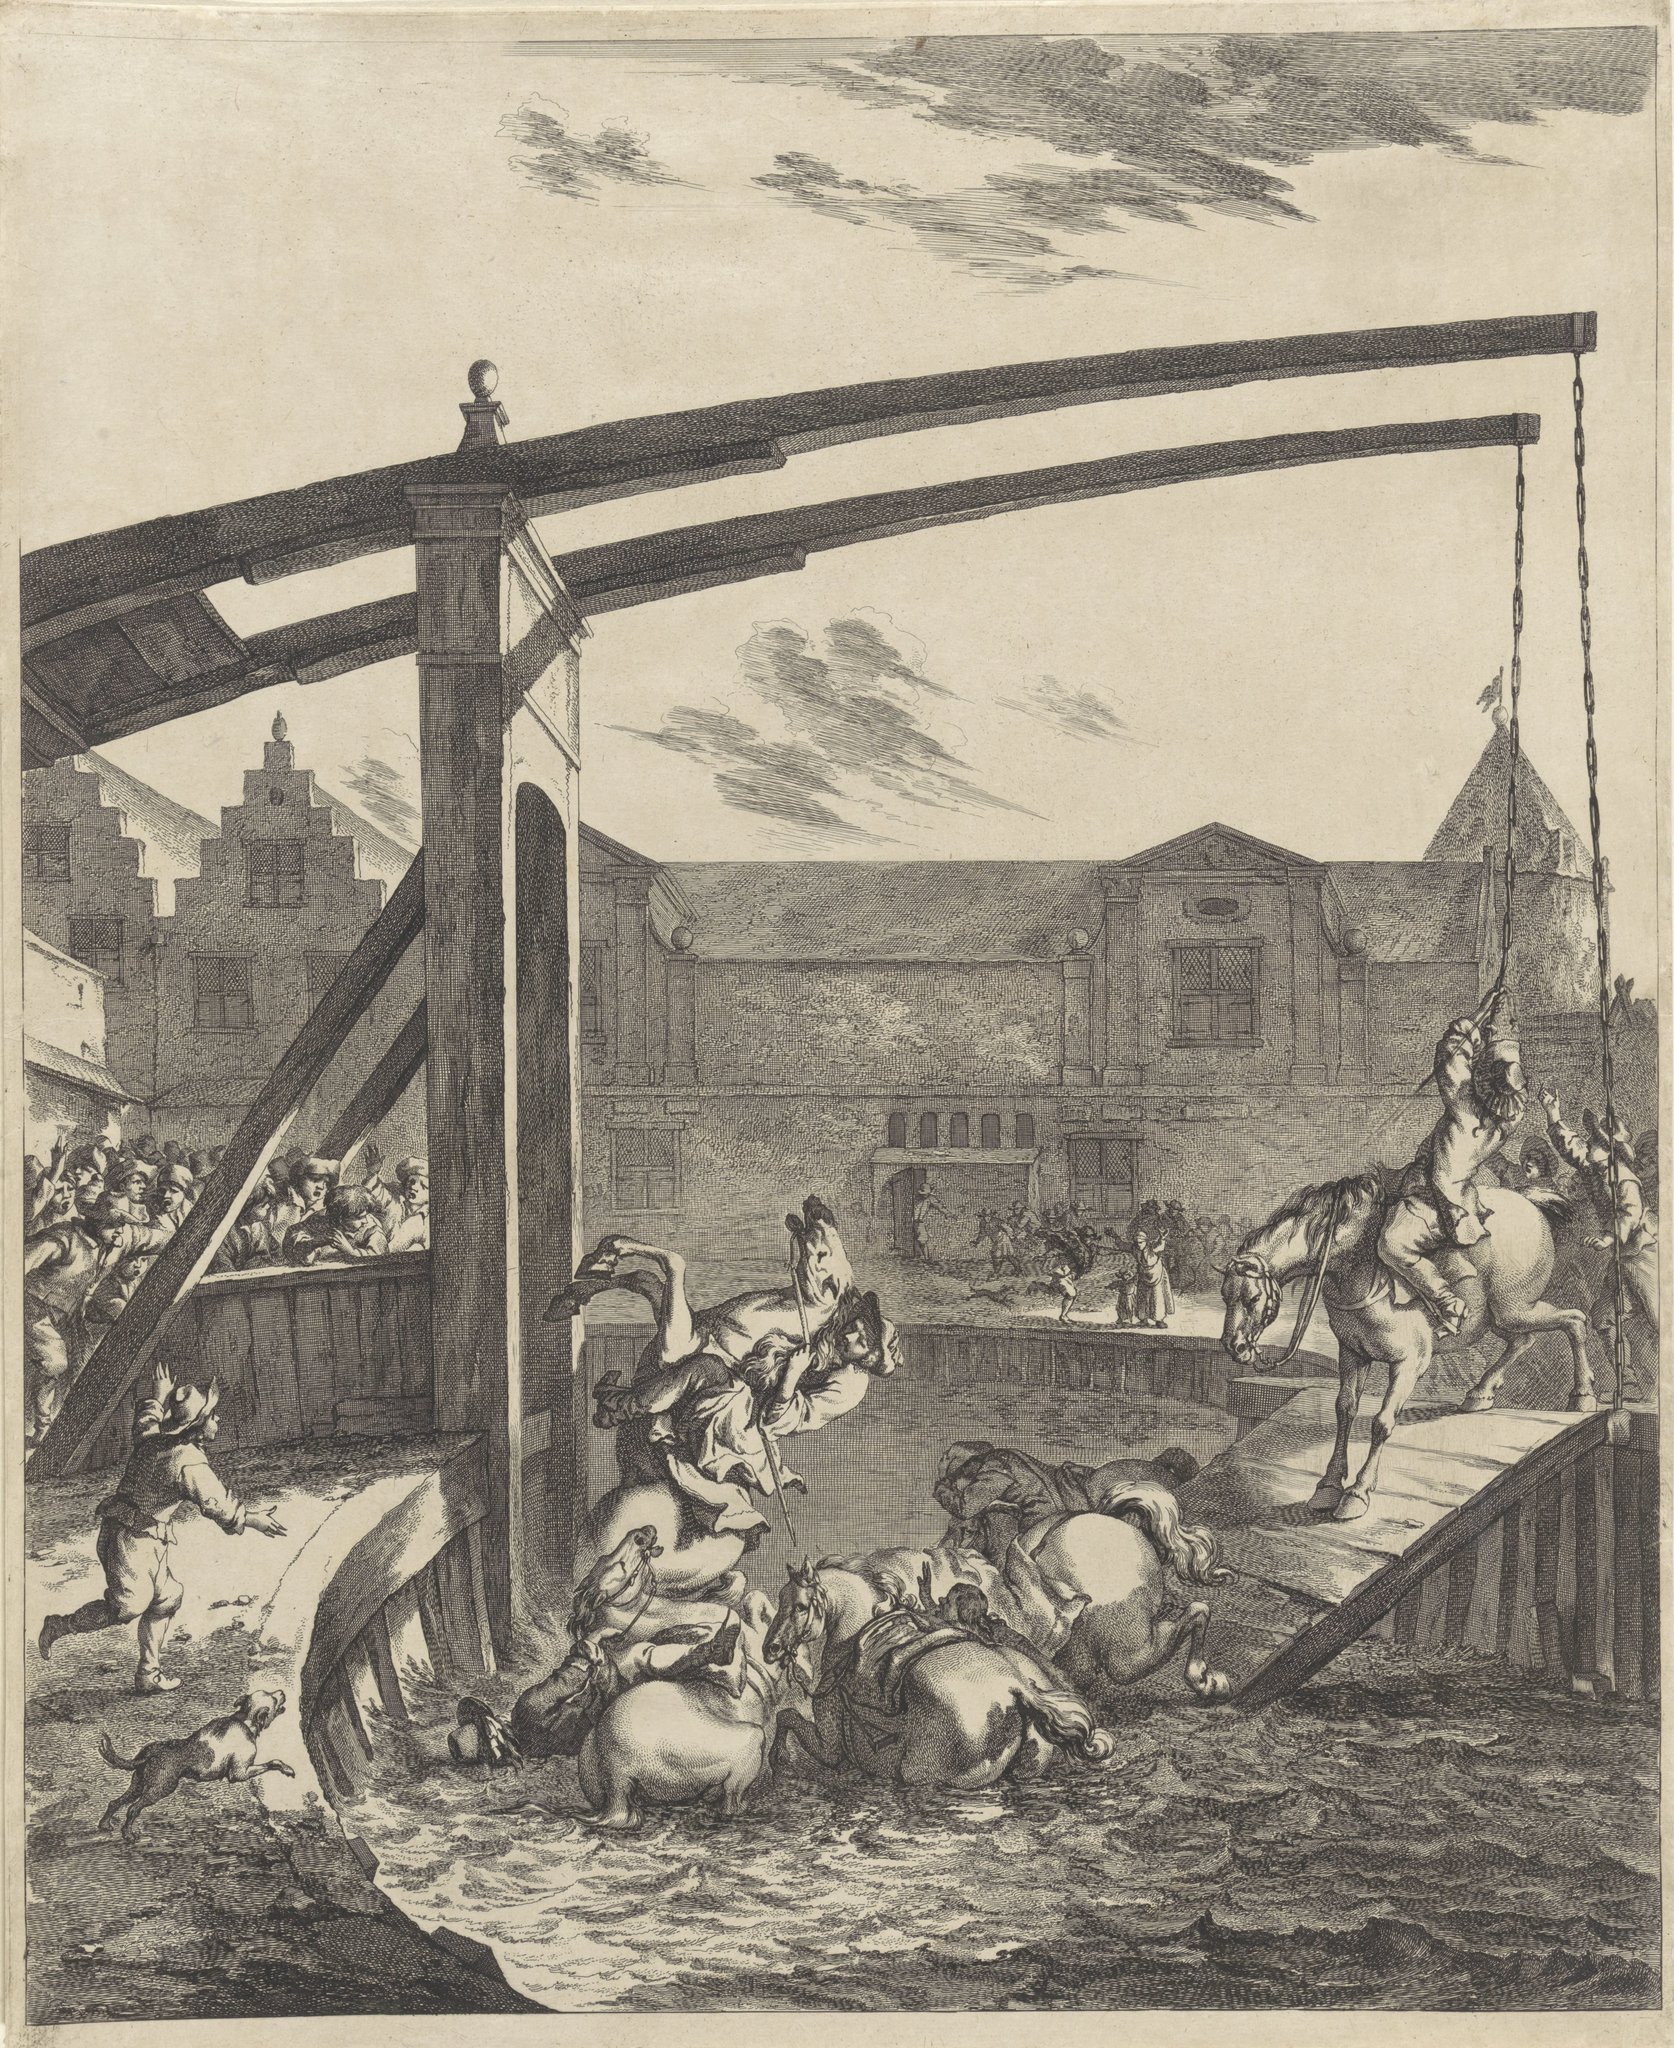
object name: print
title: Ongeluk van graaf Johan Maurits op de brug van Franeker, 1665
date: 1665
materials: paper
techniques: etching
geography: northern netherlands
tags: collapsing building, bridge, accident with horse (or kindred animal)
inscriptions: collector's mark: Lugt 573, collector's mark: Lugt 12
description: Ongeluk van graaf Johan Maurits op de brug van Franeker, 6 januari 1665. De ophaalbrug waar de graaf met zijn gevolg overheen rijdt stort in en de graaf valt in het water.